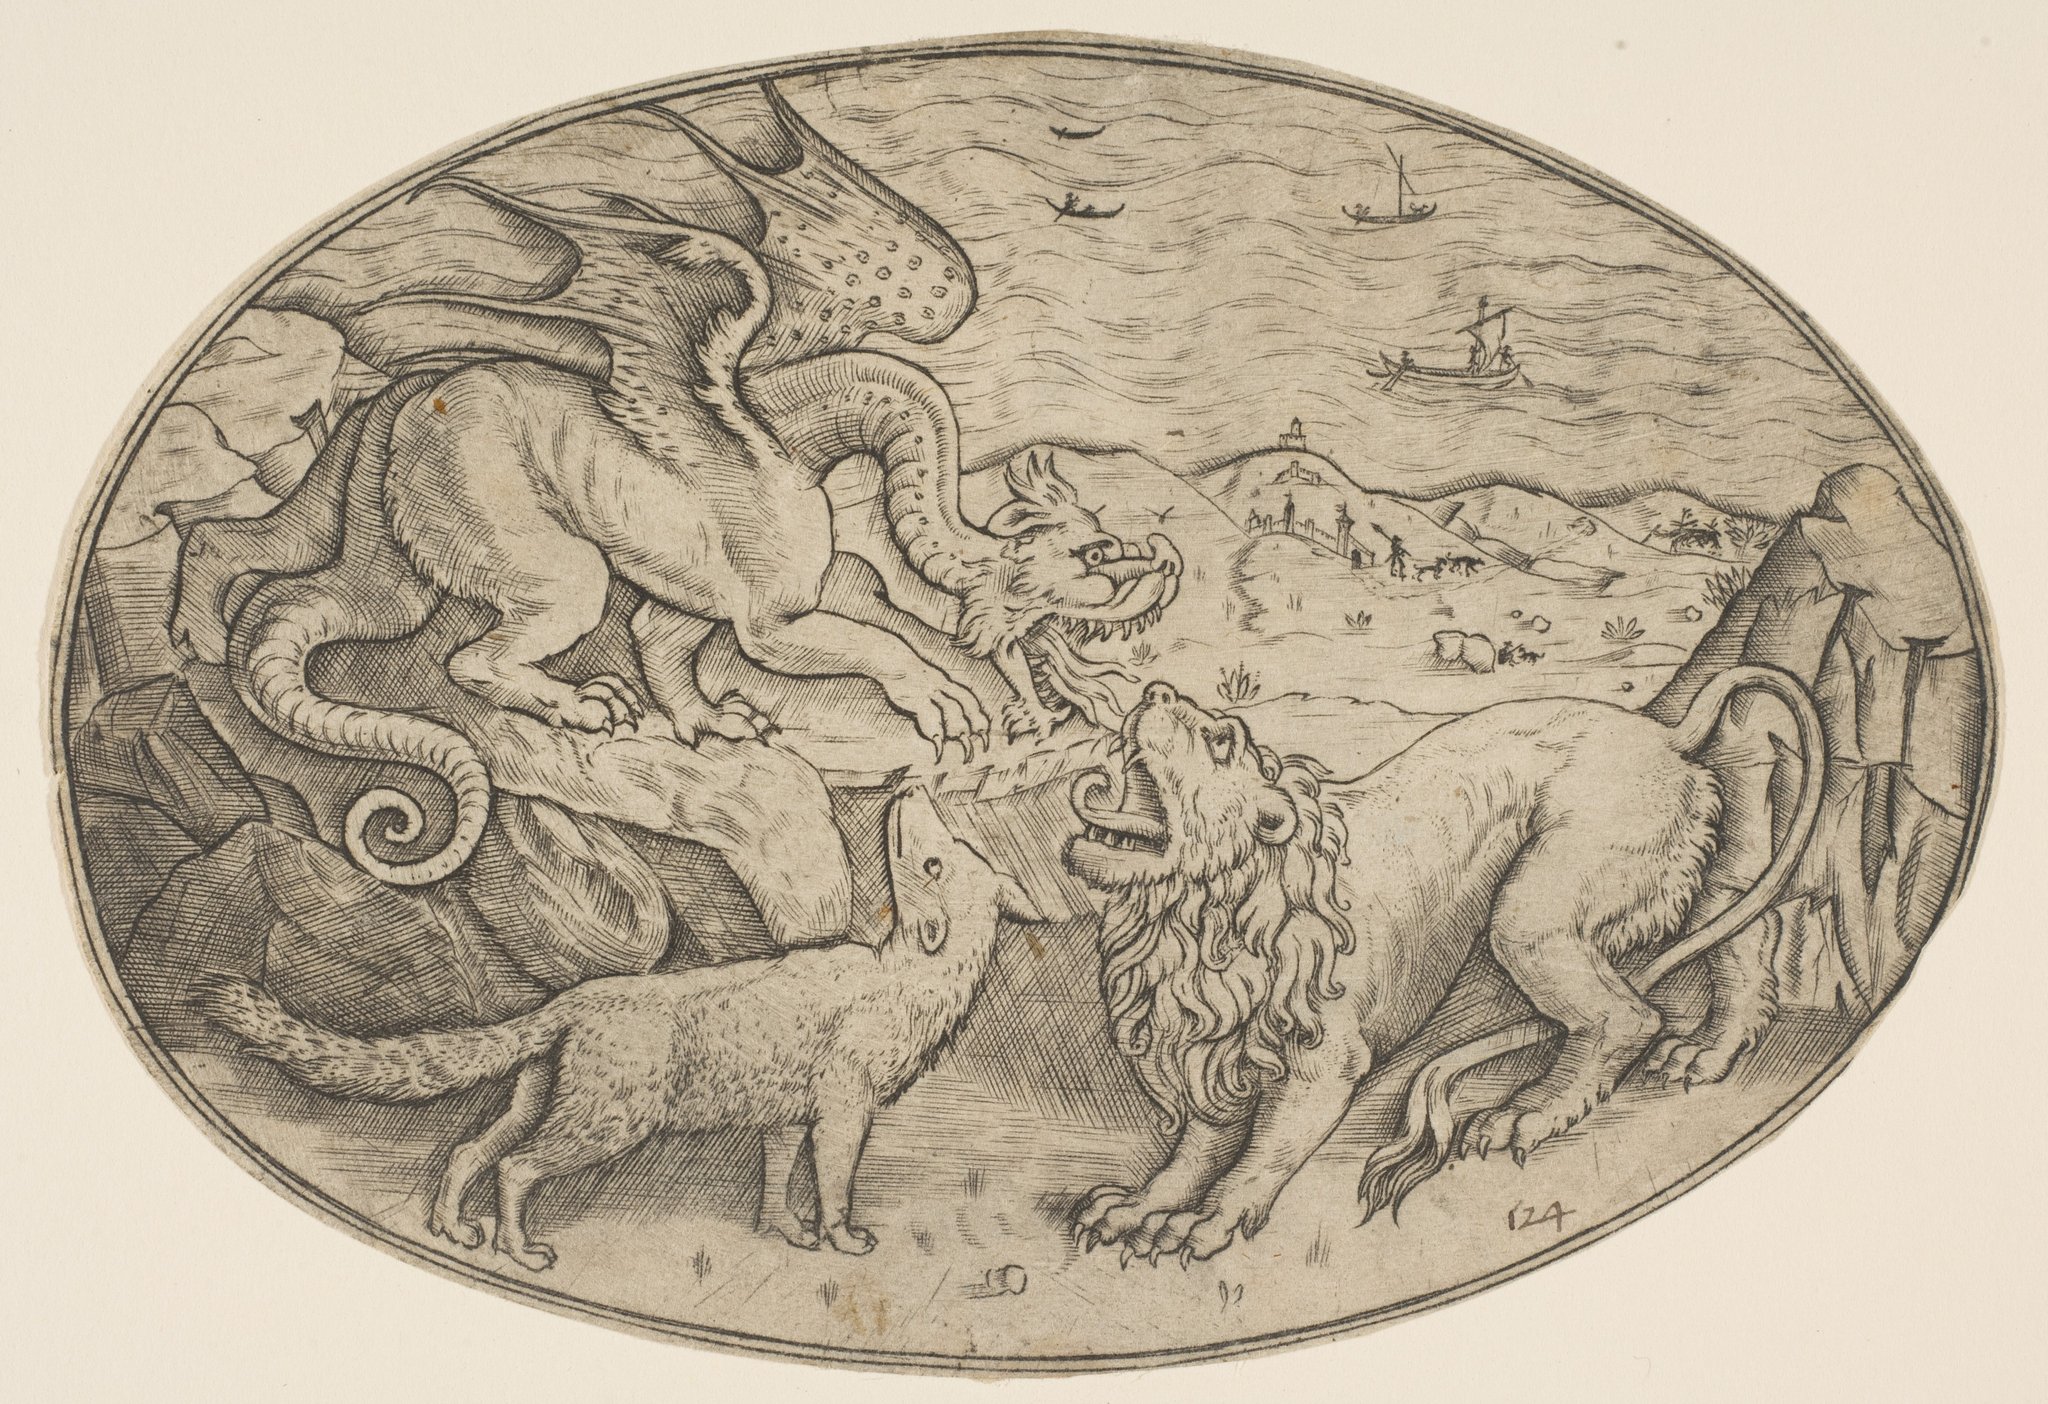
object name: print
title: A lion, dragon and fox fighting each other, boats on the sea in the background, an oval composition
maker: anonymous, italian, 16th to early 17th century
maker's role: artist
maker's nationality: italian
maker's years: 1500-1640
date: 1515-1600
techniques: engraving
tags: dragons,foxes,lions